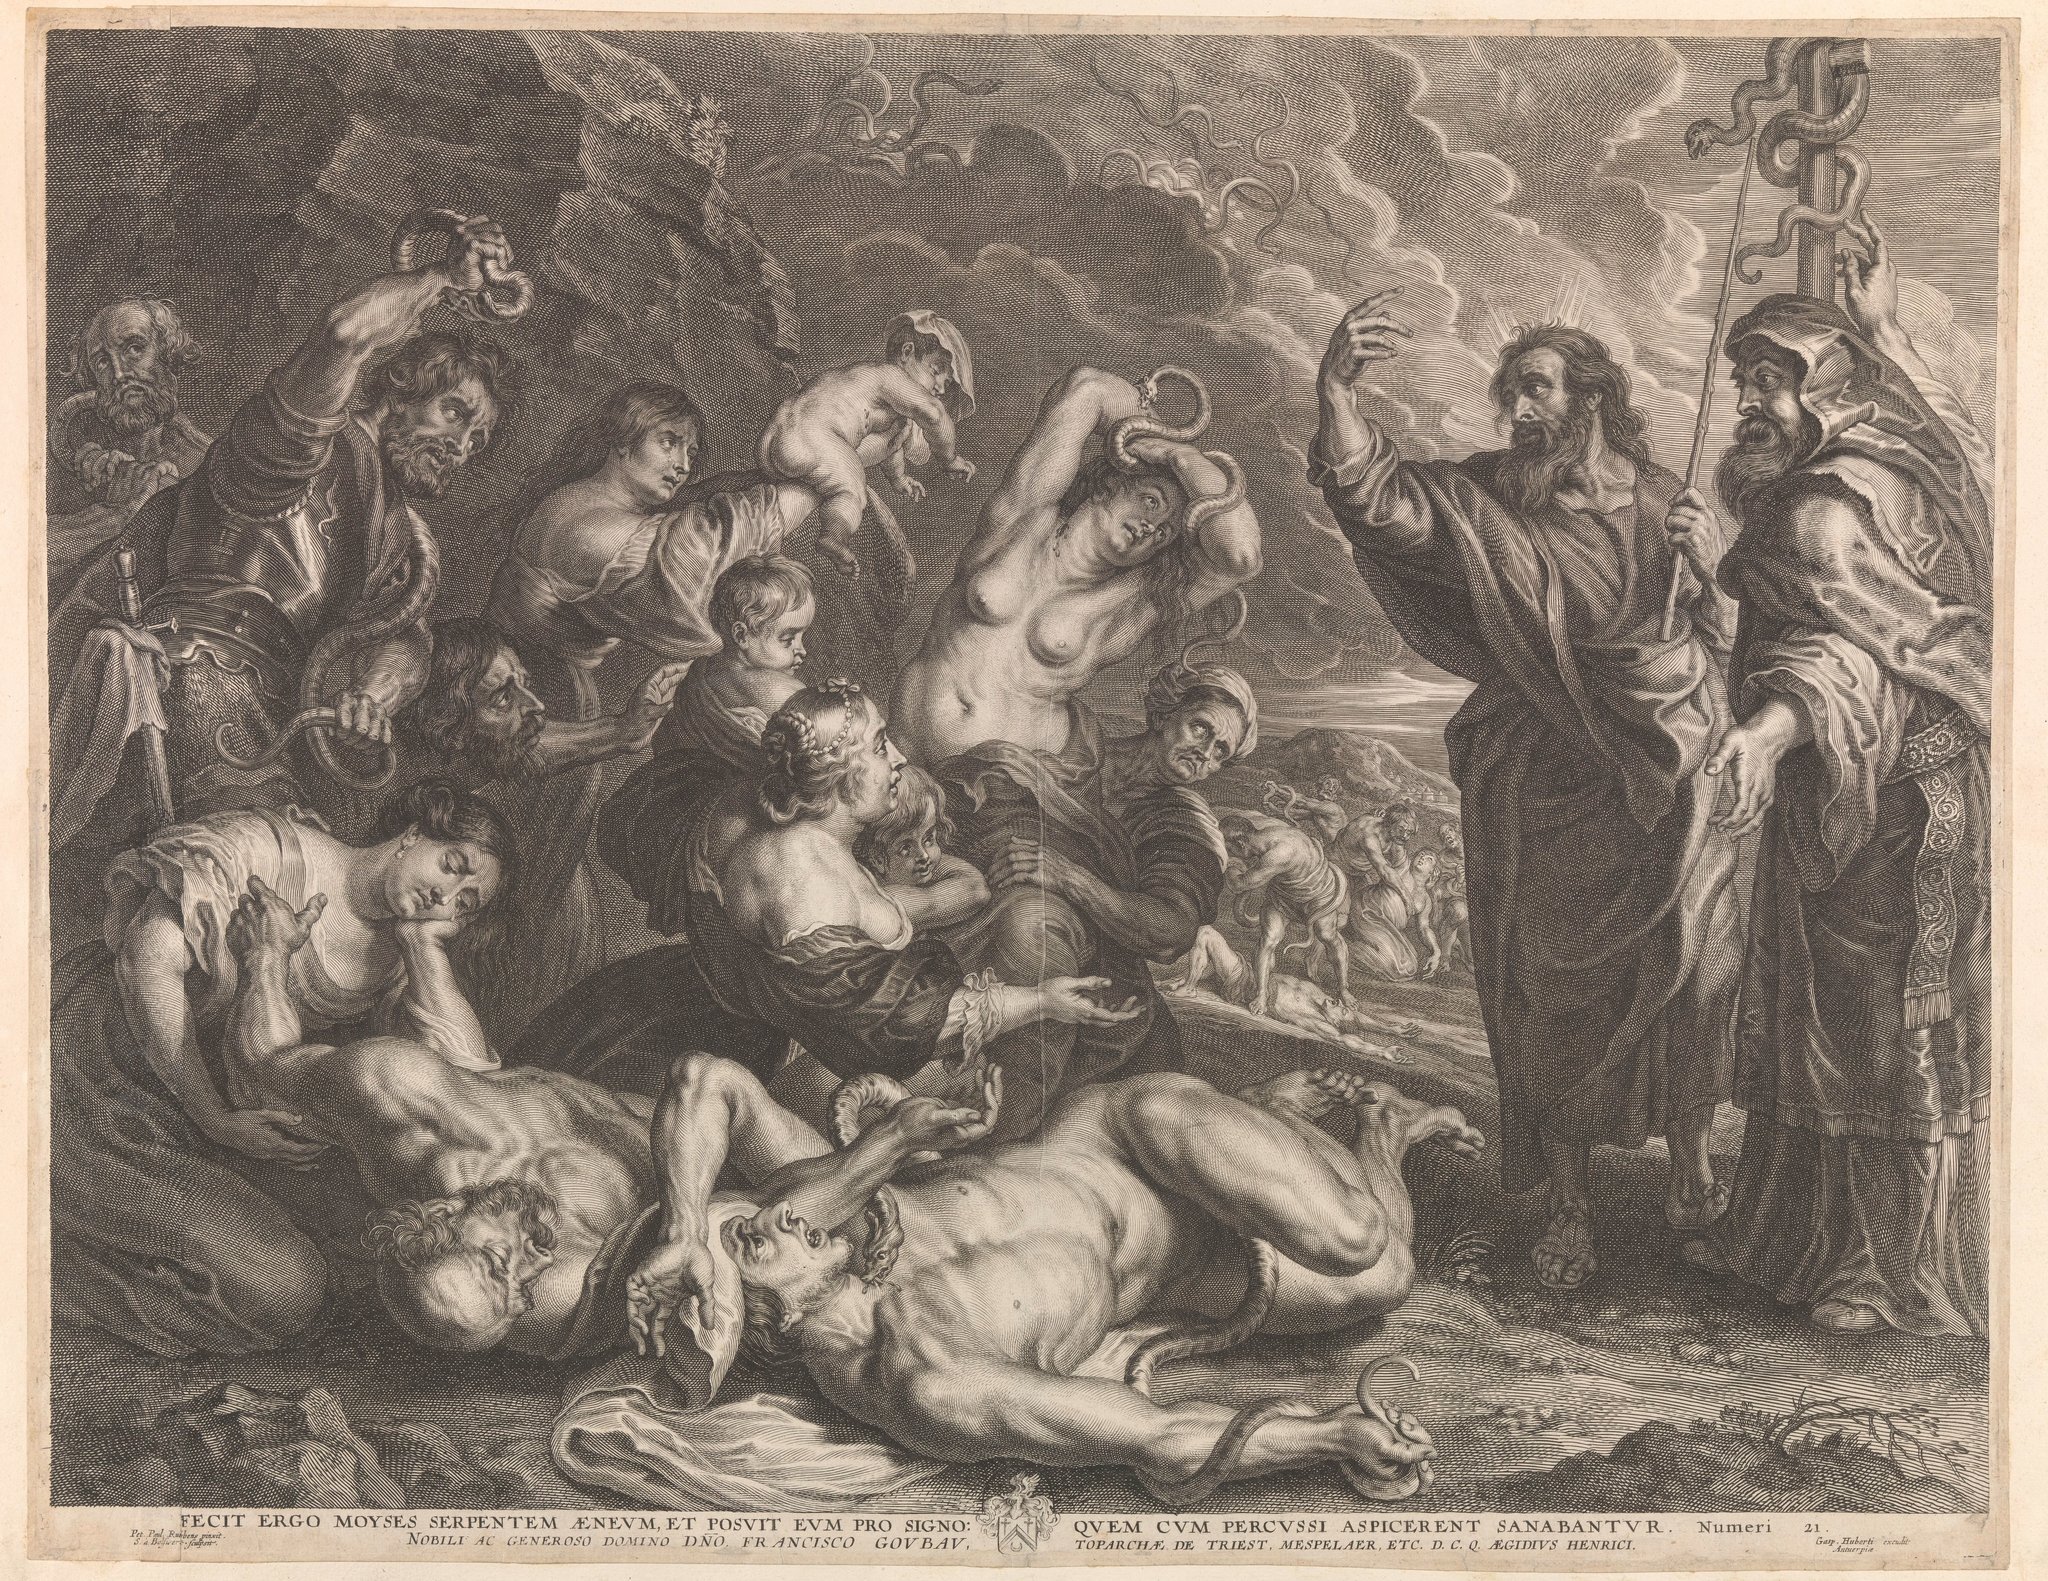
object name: album leaf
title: Oprichting van de koperen slang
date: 1596-1659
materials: paper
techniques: engraving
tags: the brazen serpent (numbers 21:4-9)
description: De oprichting van de koperen slang. Rechts staan Aäron en Mozes naast de op een staak bevestigde koperen slang. Mannen, vrouwen en kinderen, die door giftige slangen worden gebeten kijken naar de koperen slang om in leven te blijven. Onder de voorstelling de titel in het Latijn en een verwijzing naar de Bijbeltekst in Num. 21. Deze prent maakt deel uit van een album.